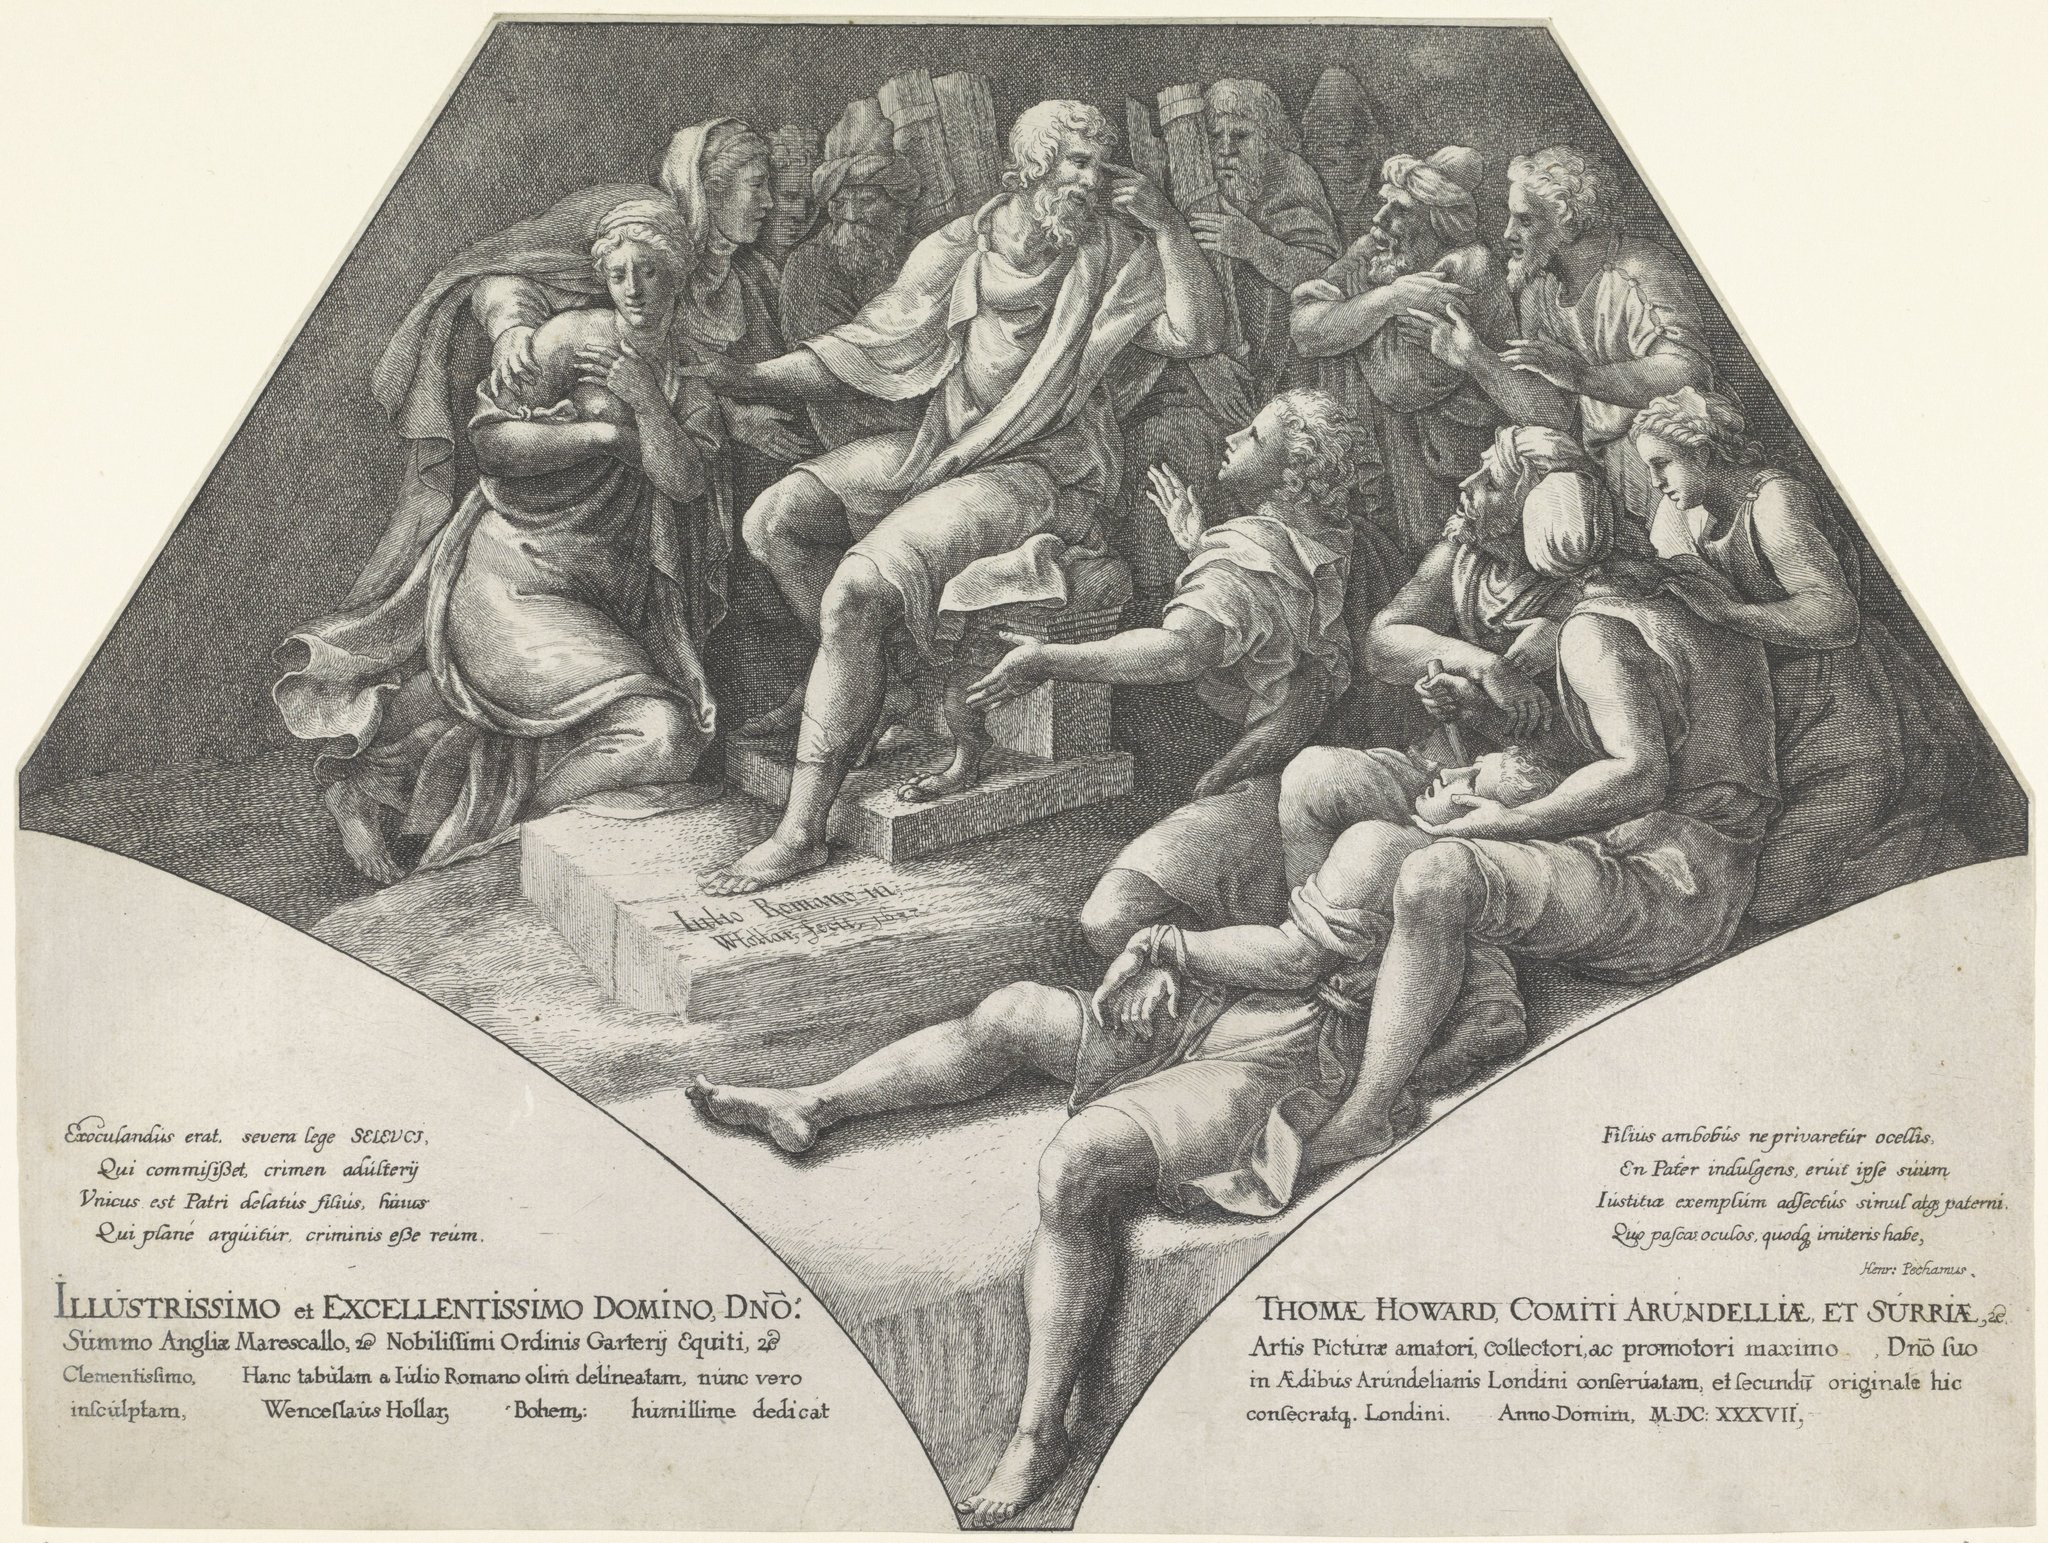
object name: print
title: Oordeel van Zaleucus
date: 1637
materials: paper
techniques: etching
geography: london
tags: the judgement of zaleucus: when zaleucus' son is sentenced to be blinded in both eyes, zaleucus has one of his son's eyes plucked out and one of his own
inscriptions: collector's mark: Lugt 240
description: Rechter Zaleucus zetelt op een troon en wijst op zijn oog die is uitgestoken. Rechts ligt de schuldige zoon, vastgehouden door drie mannen, terwijl ook bij hem één oog wordt uitgestoken.